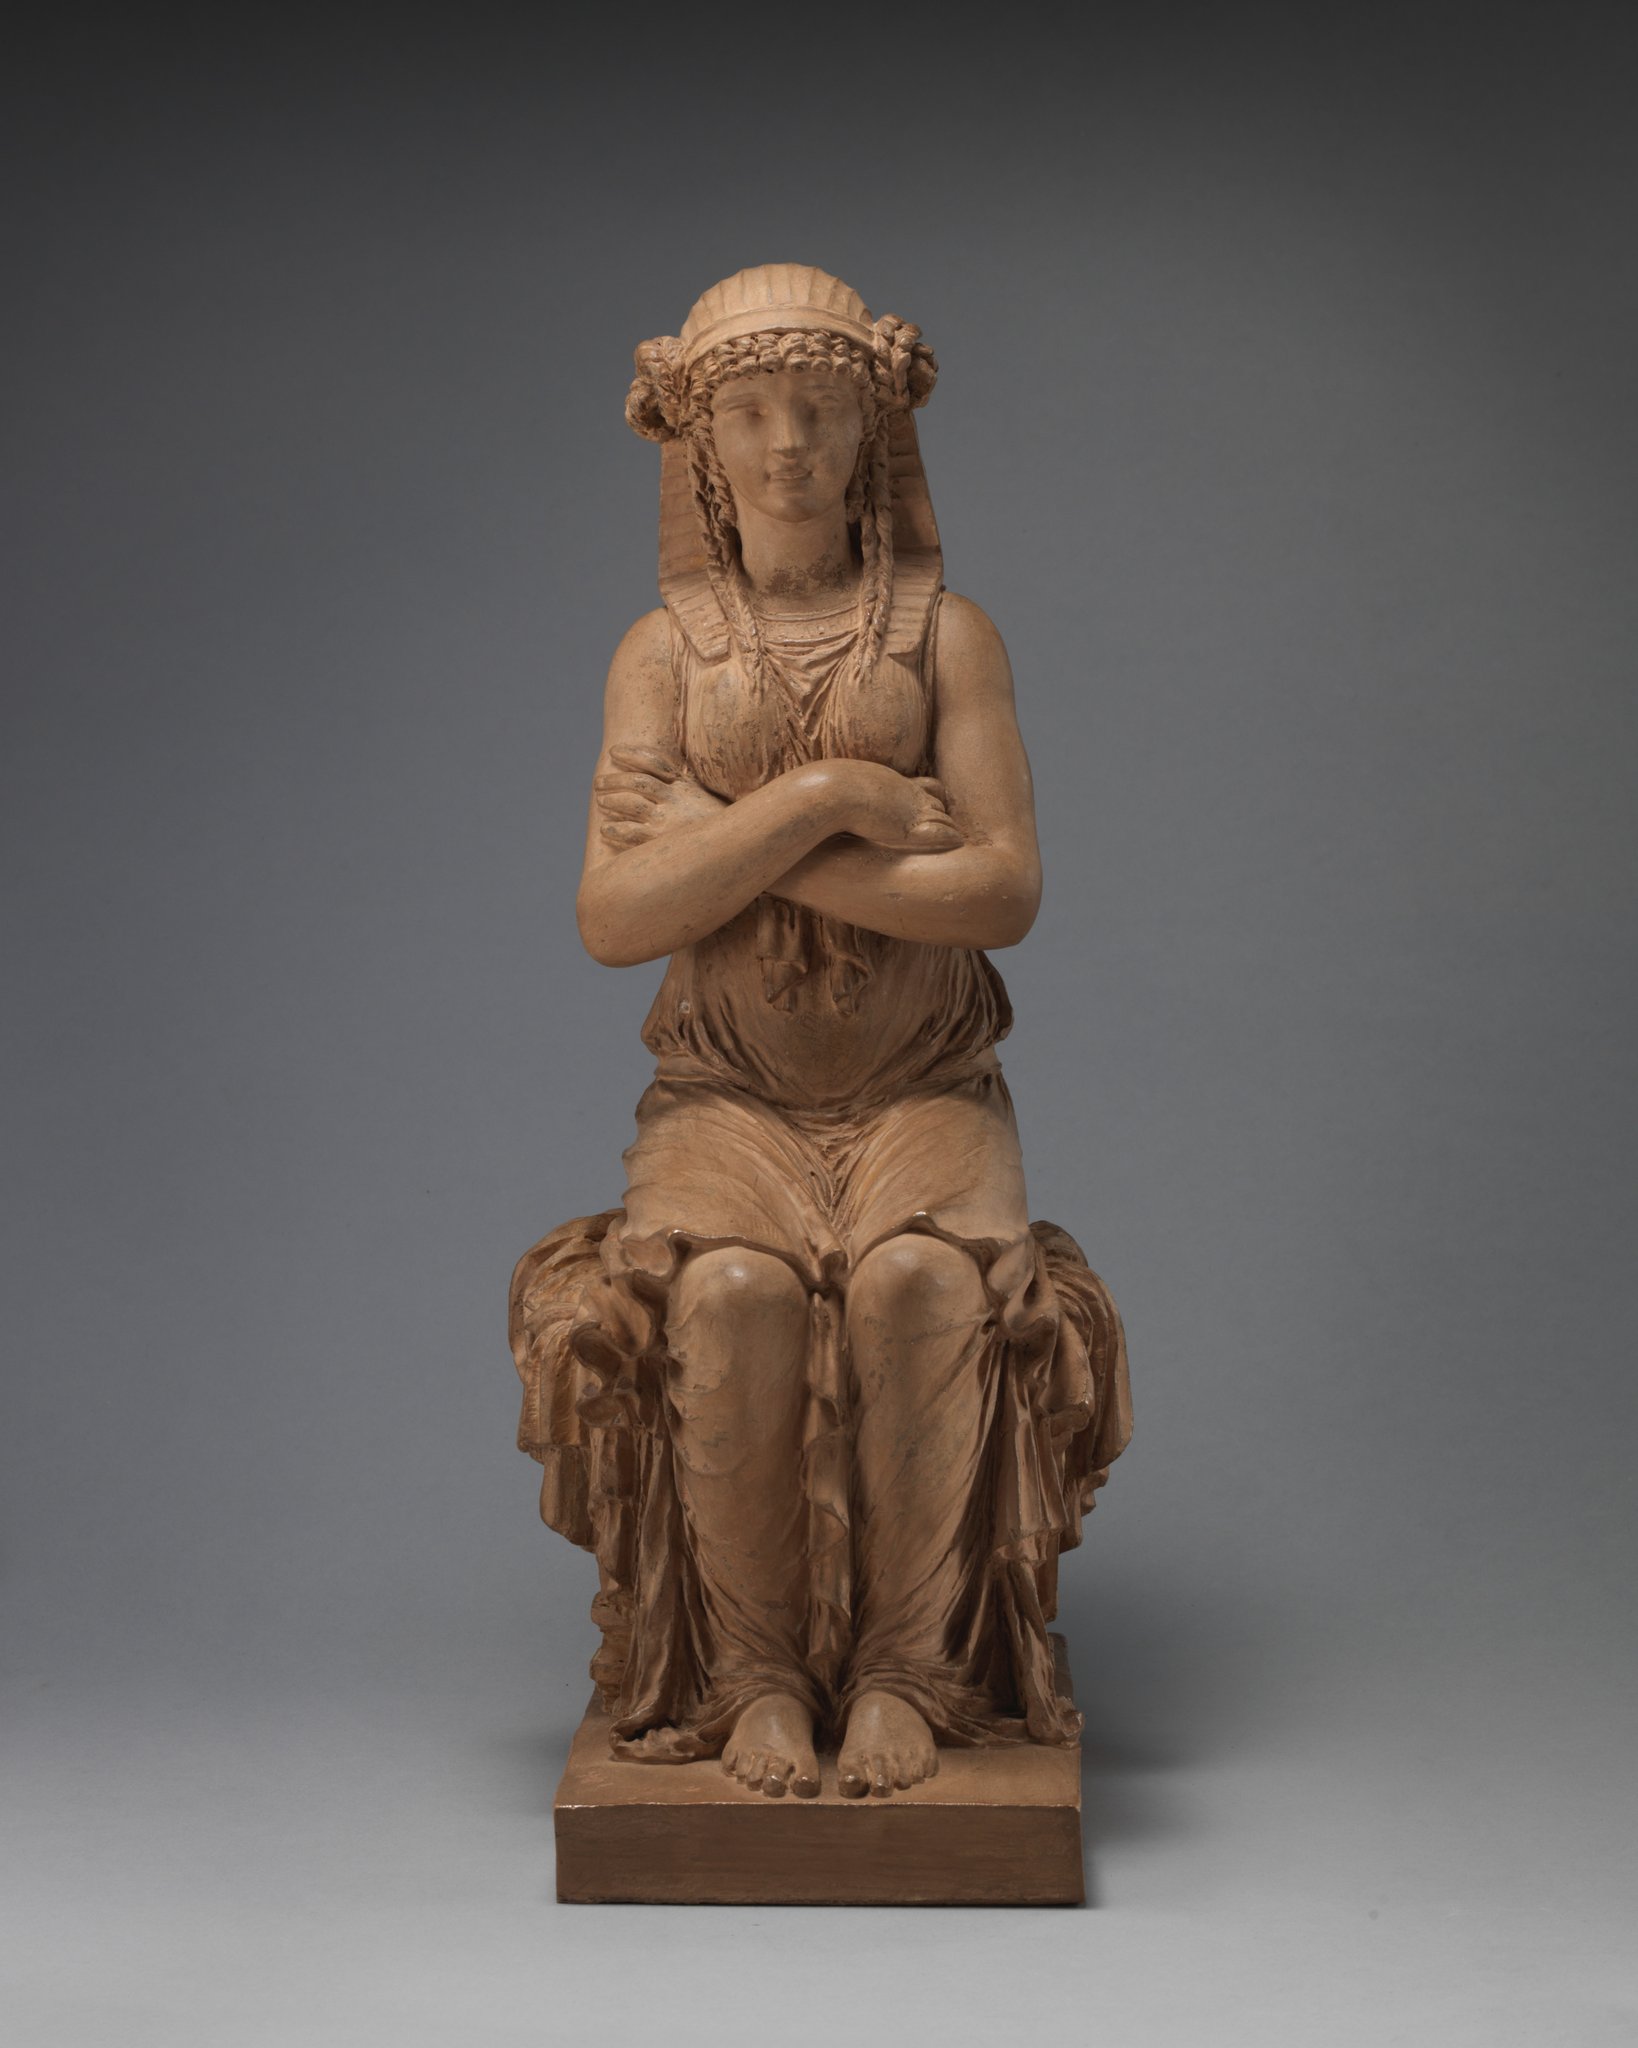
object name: statuette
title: Egyptian Goddess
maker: clodion (claude michel)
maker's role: artist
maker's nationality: french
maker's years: 1738-1814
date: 1780-1789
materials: terracotta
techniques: painting